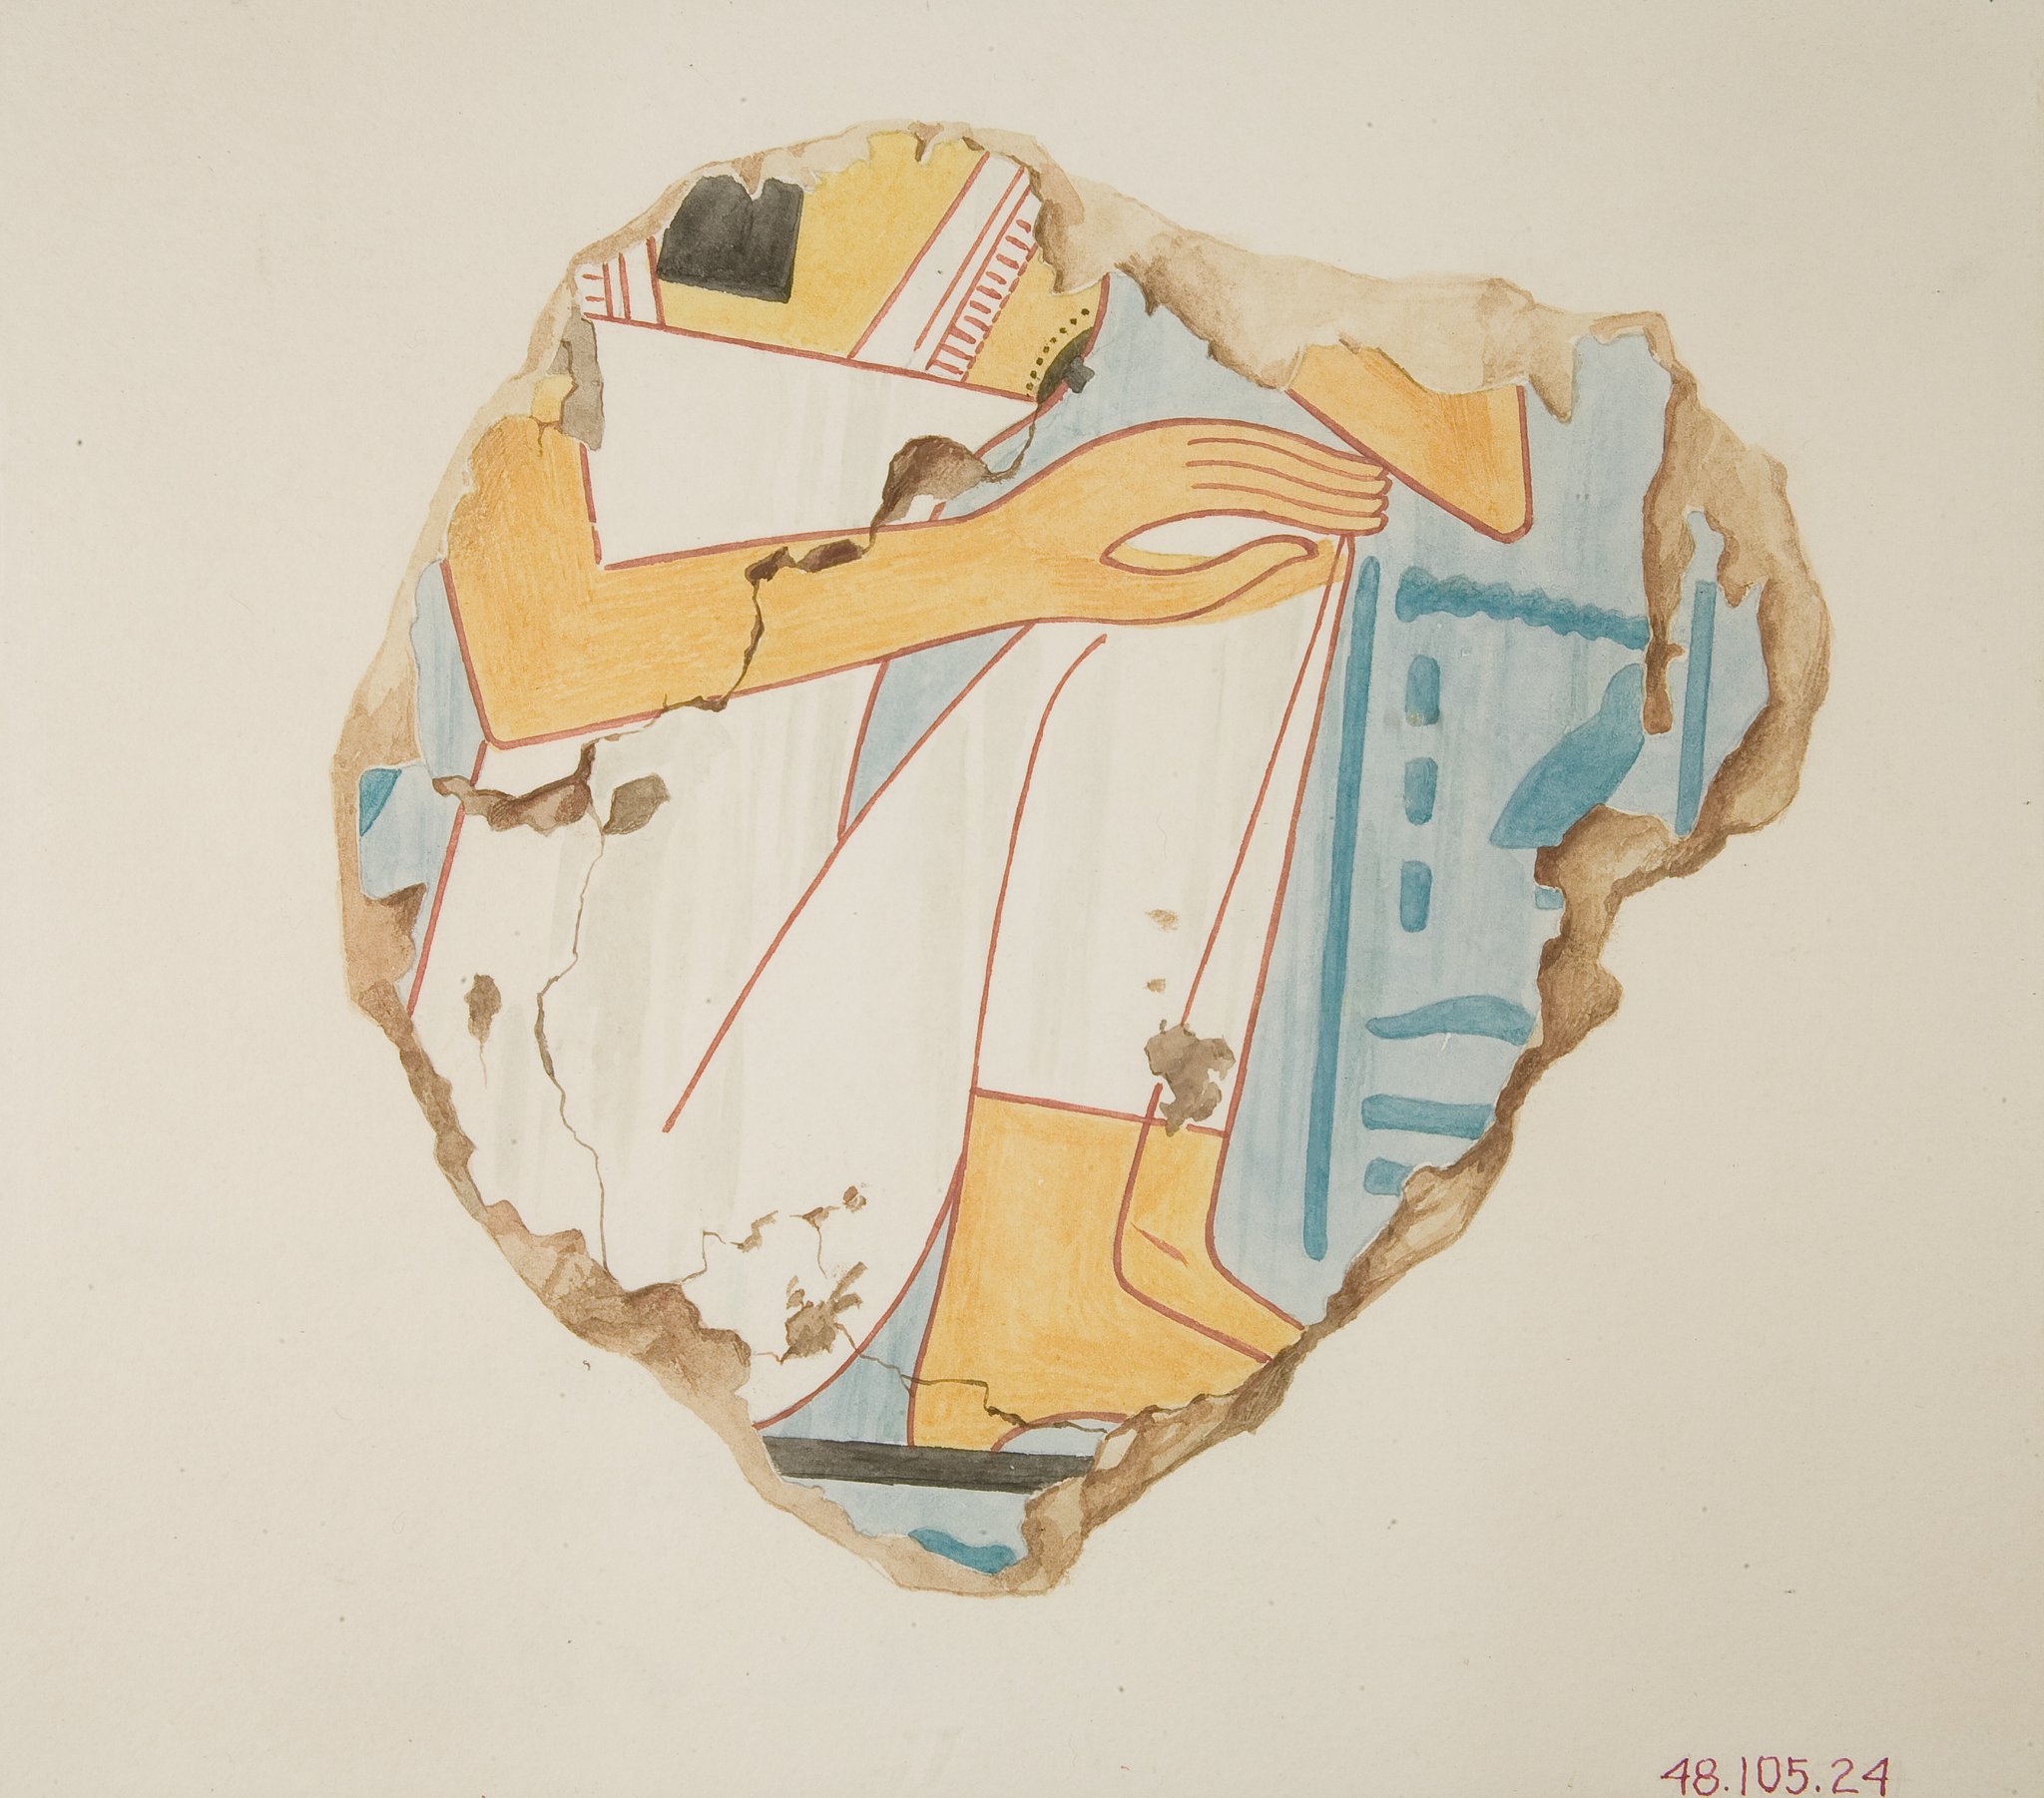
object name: facsimile, thebe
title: Seated Woman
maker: nina de garis davies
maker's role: artist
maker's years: 1881-1965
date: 1567-1482 BCE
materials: paper, paint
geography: egypt